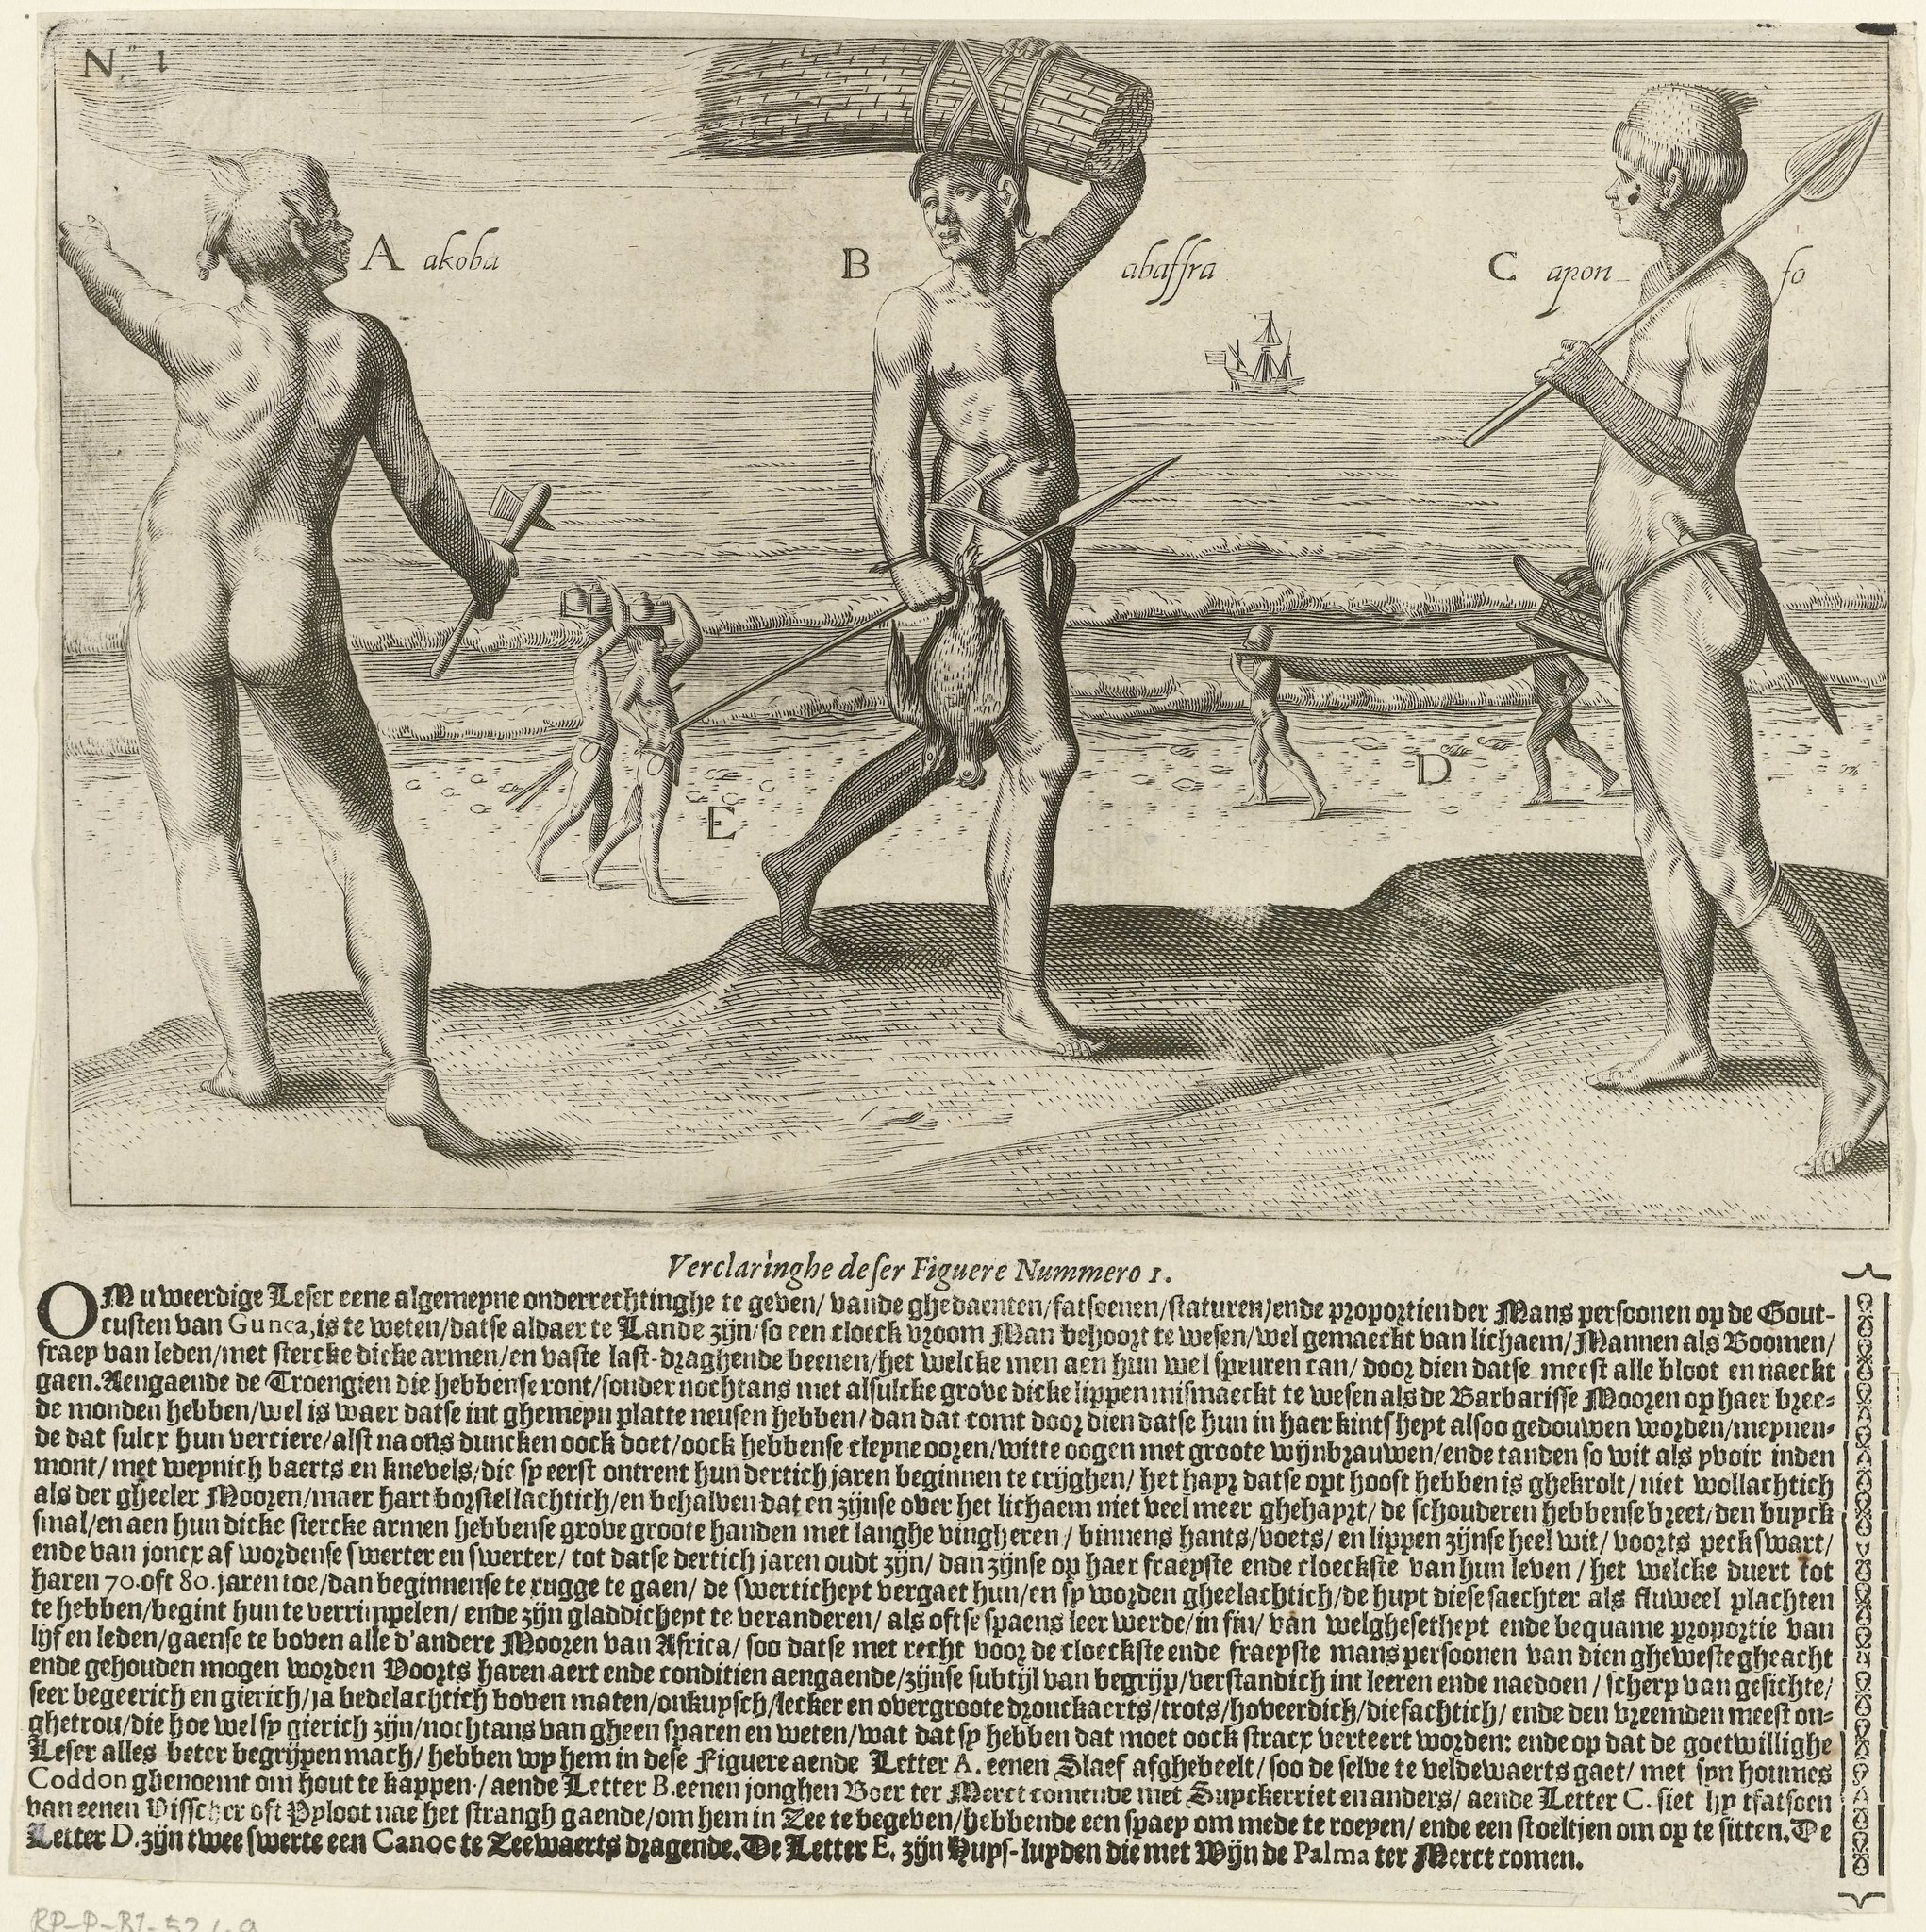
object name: book illustration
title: Beschrijving van de goudkusten van Guinea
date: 1602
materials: paper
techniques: engraving, letterpress printing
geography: frankfurt am main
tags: africans, slavery; serfs and enslaved persons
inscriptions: collector's mark: Lugt 240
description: Verschillende bevolkingsgroepen in Guinea en hun bijzondere eigenheden. A: een tot slaaf gemaakte man, B: een boer die met suikerriet naar de markt gaat, C: een visser, D: twee zwarte mannen die een boot naar het strand dragen, E: twee mannen die wijn naar de markt brengen. Onder de voorstelling een beschrijving van de bevolking van Guinea en een uitleg over de verschillende groepen.